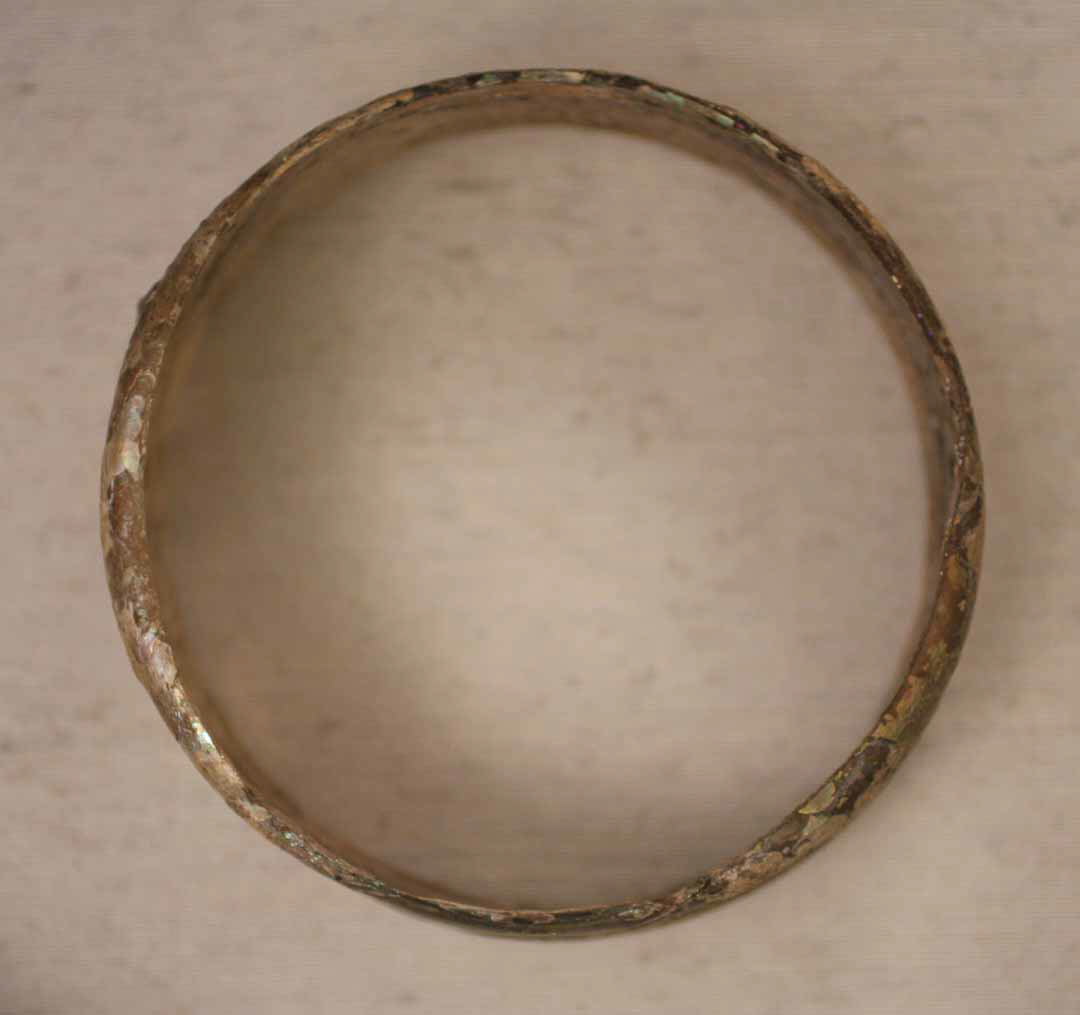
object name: bowl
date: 601-800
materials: glass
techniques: glassblowing, tooling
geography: iraq